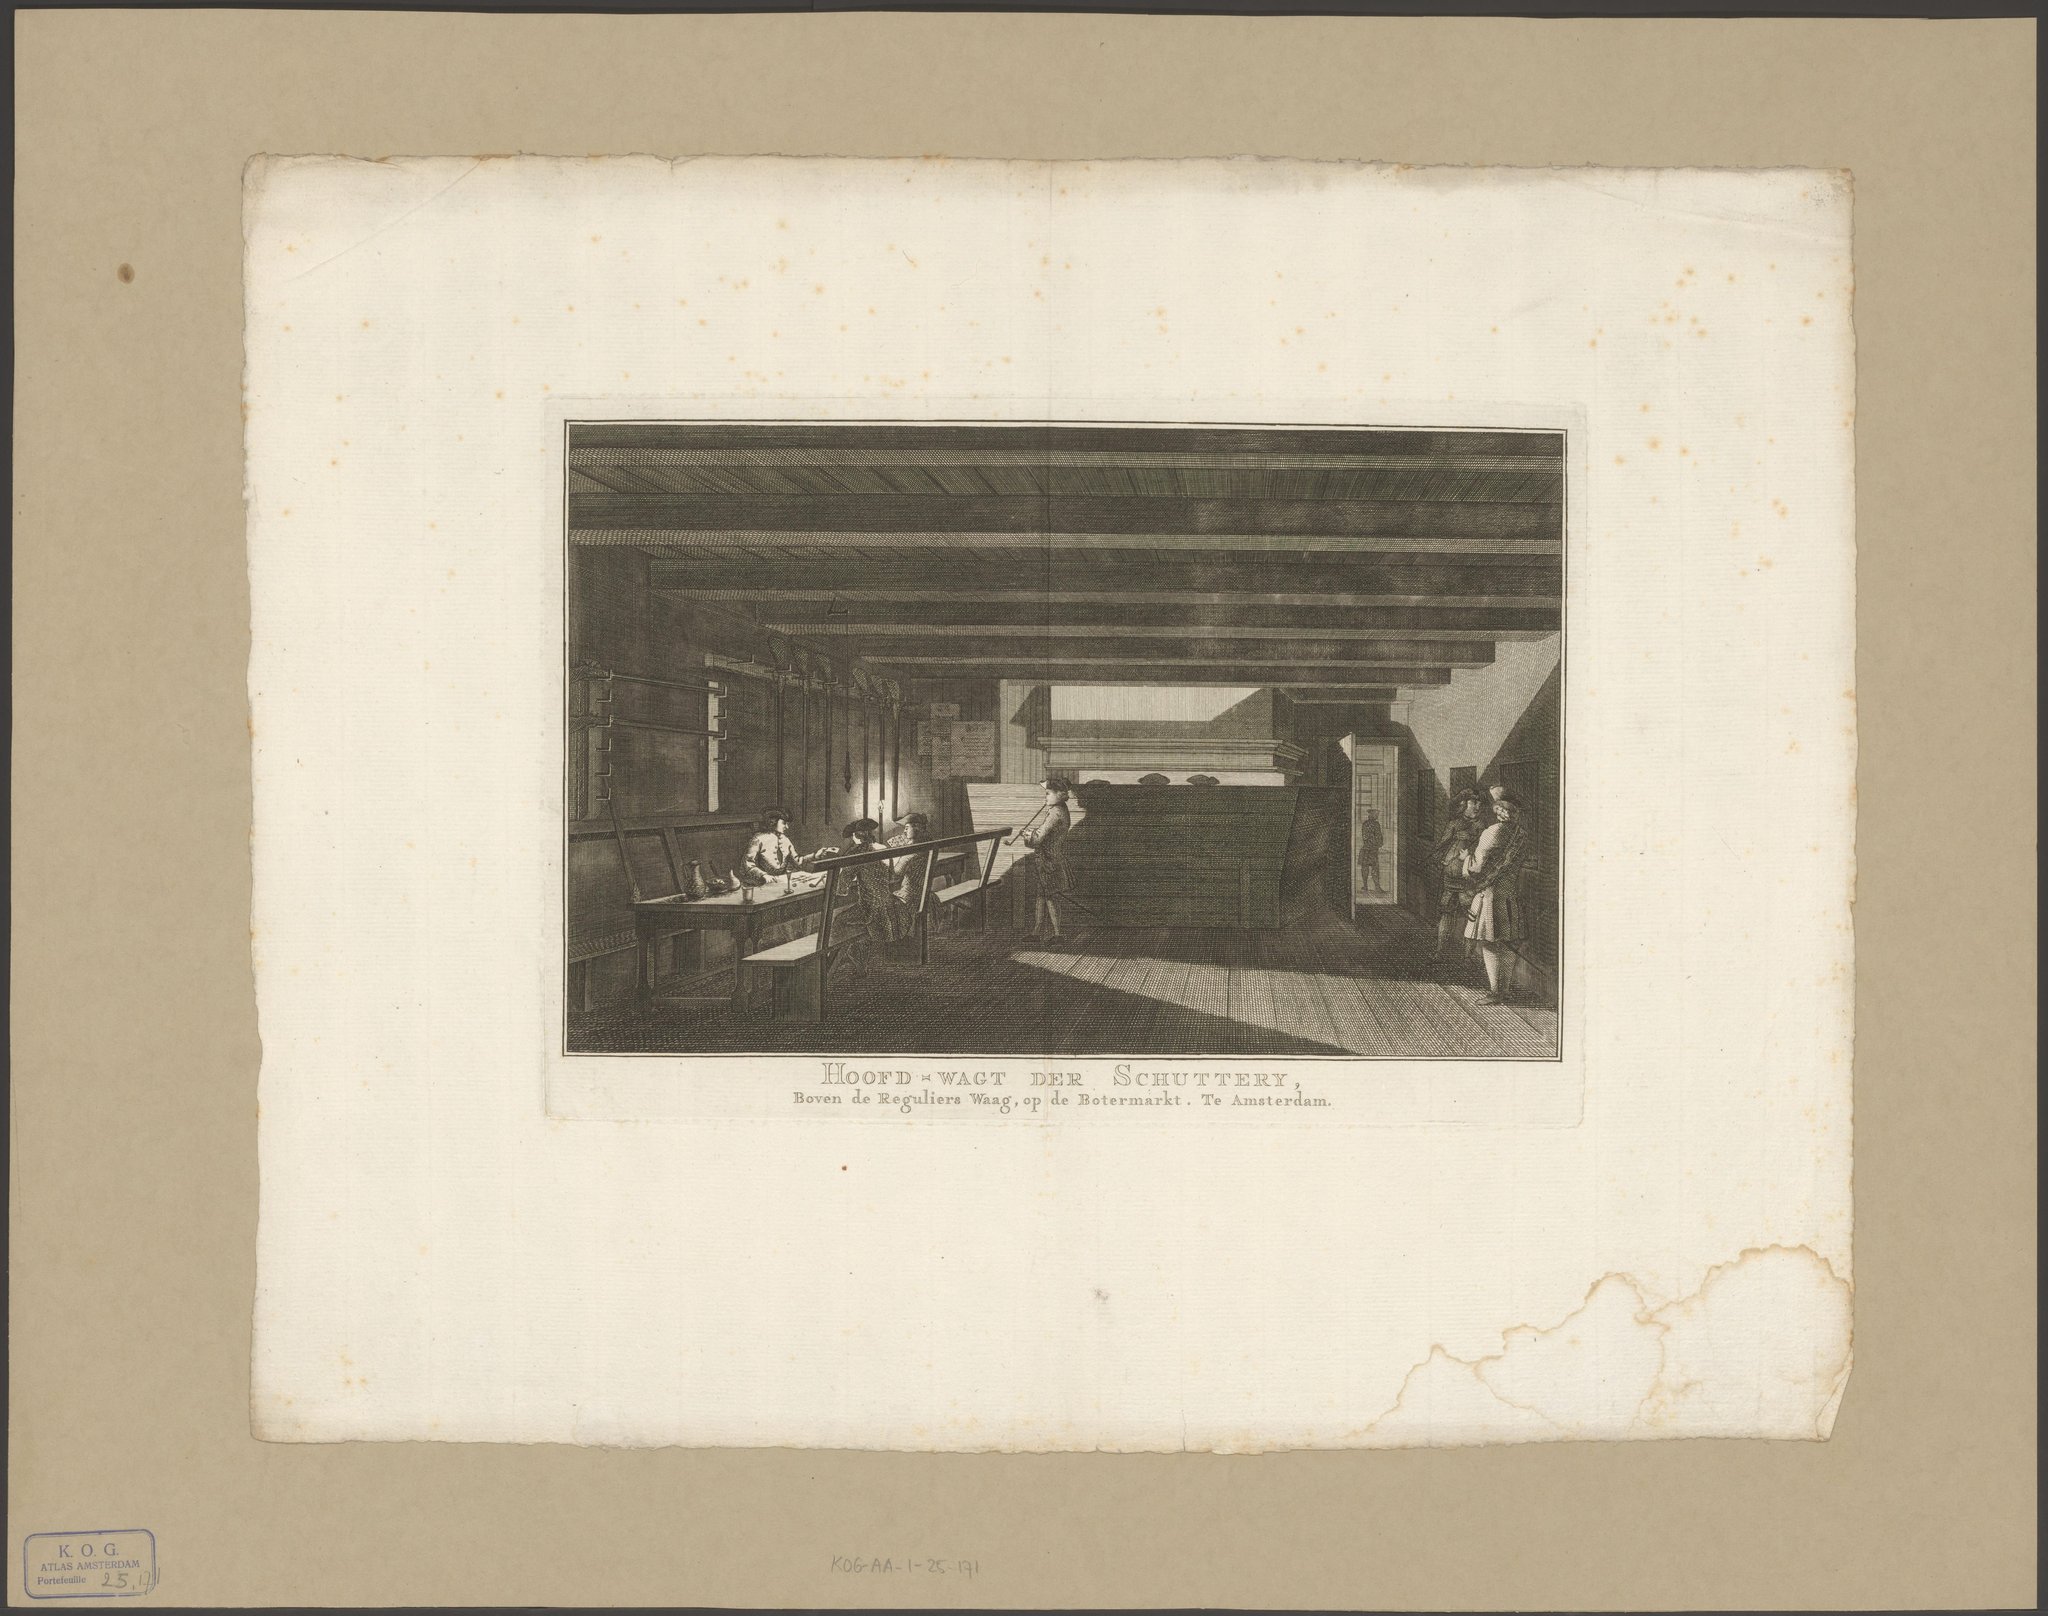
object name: print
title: Hoofd-wagt der Schuttery, Boven de Reguliers Waag, op de Botermarkt. Te Amsterdam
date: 1750-1793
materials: paper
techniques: etching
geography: amsterdam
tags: pipe ~ tobacco, playing-cards, guard duty, keeping sentry, night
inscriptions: collector's mark: ‘25.171’ Lugt 1641b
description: Onderwerpsrubriek binnen de Atlas Amsterdam: Krijgswezen I: De Admiraliteit van Amsterdam, E. Doelen en Wachthuizen.